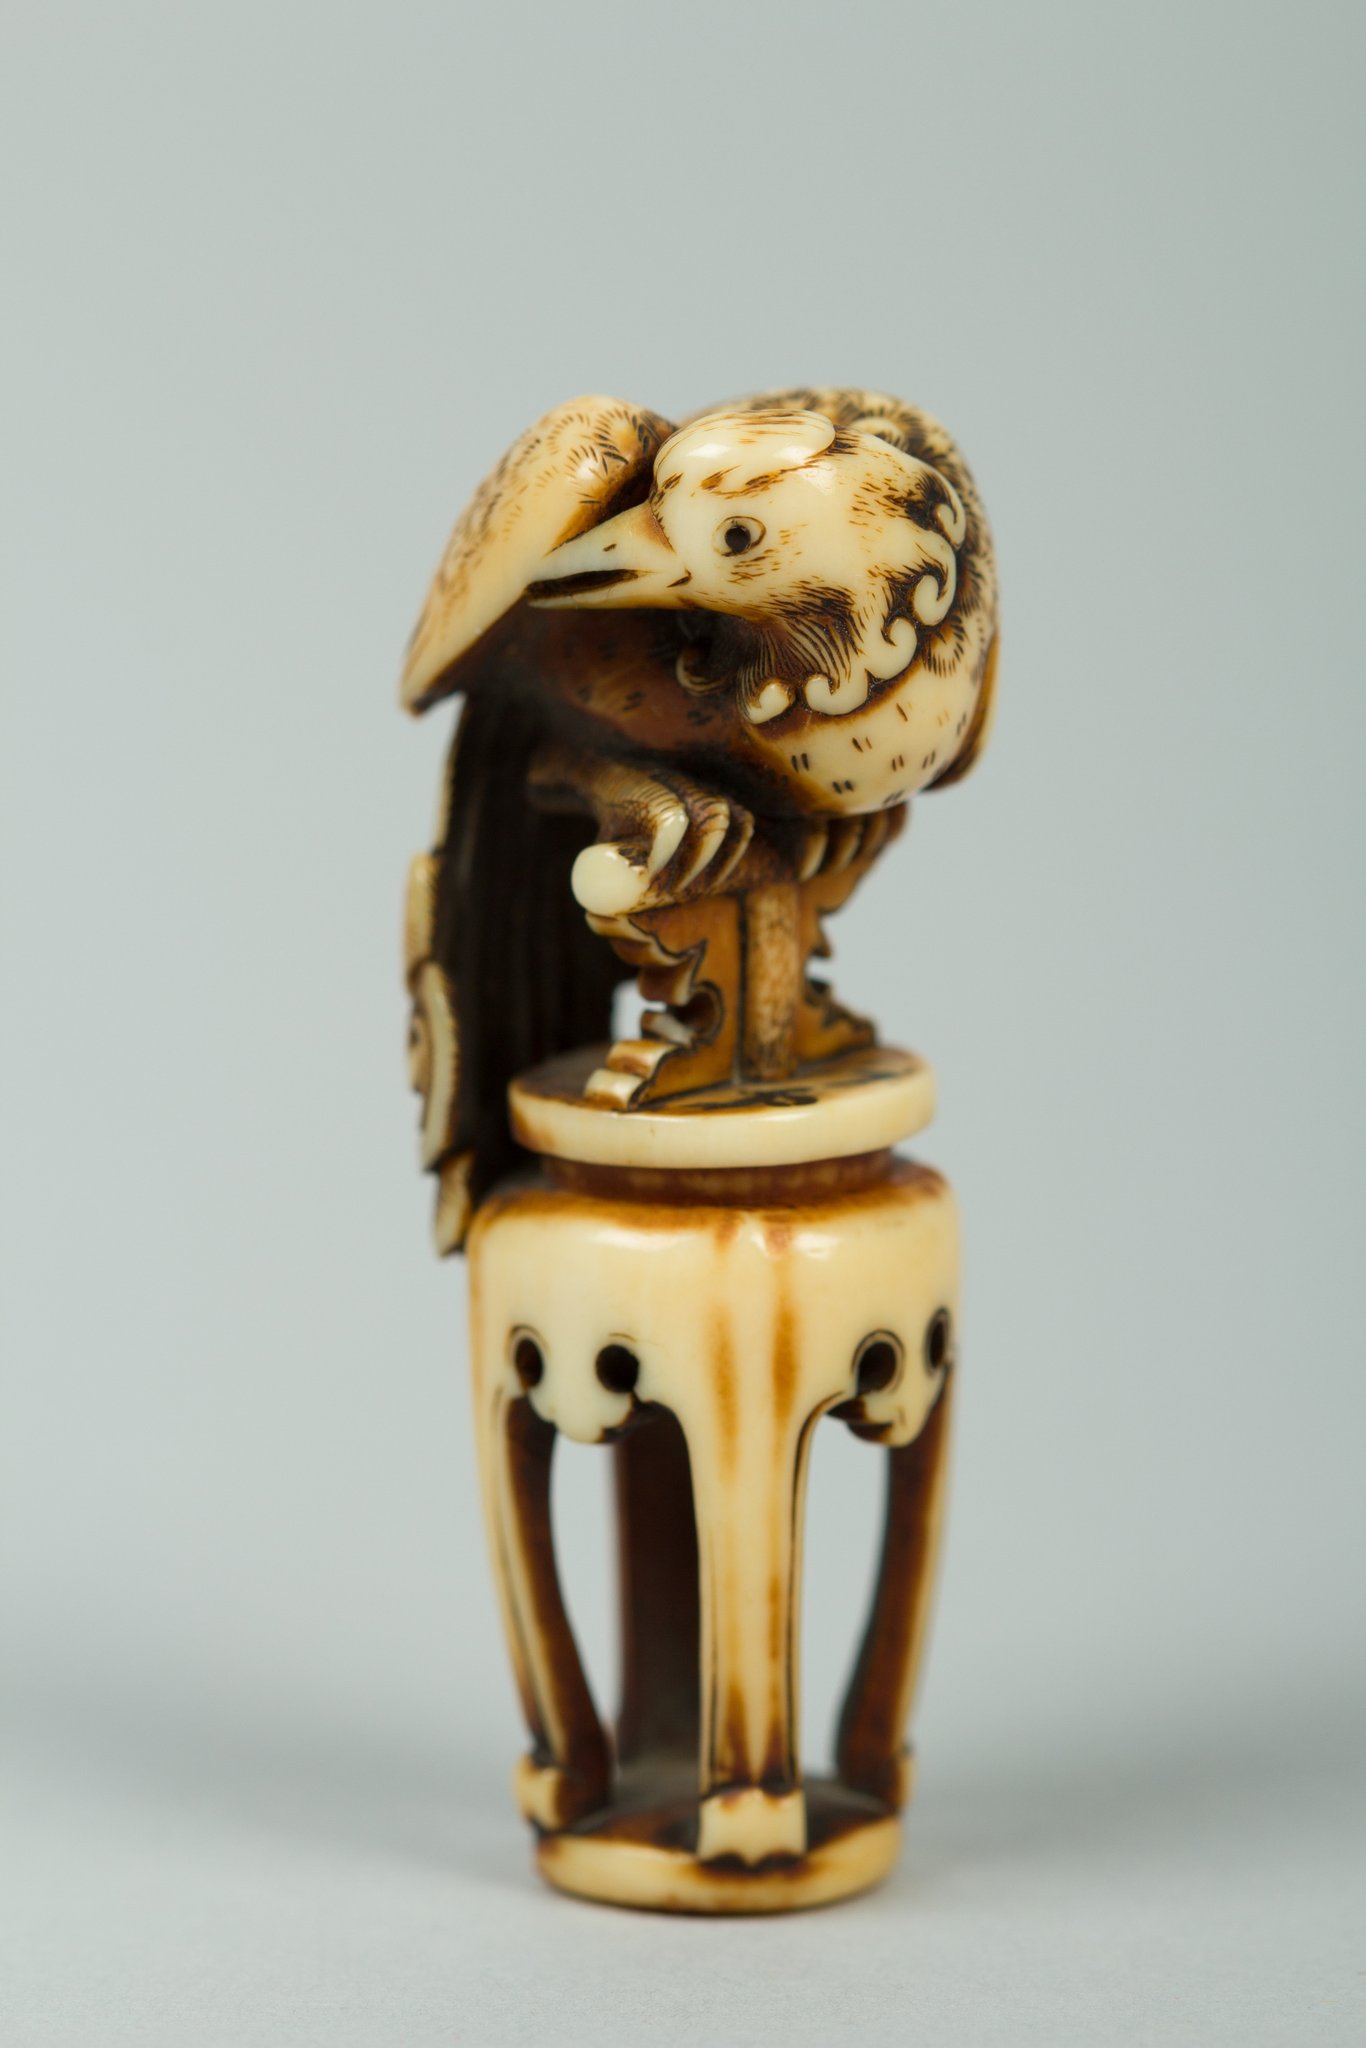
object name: netsuke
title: Netsuke of Phoenix on a Pedestal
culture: japanese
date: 1801-1900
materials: ivory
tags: birds,phoenix